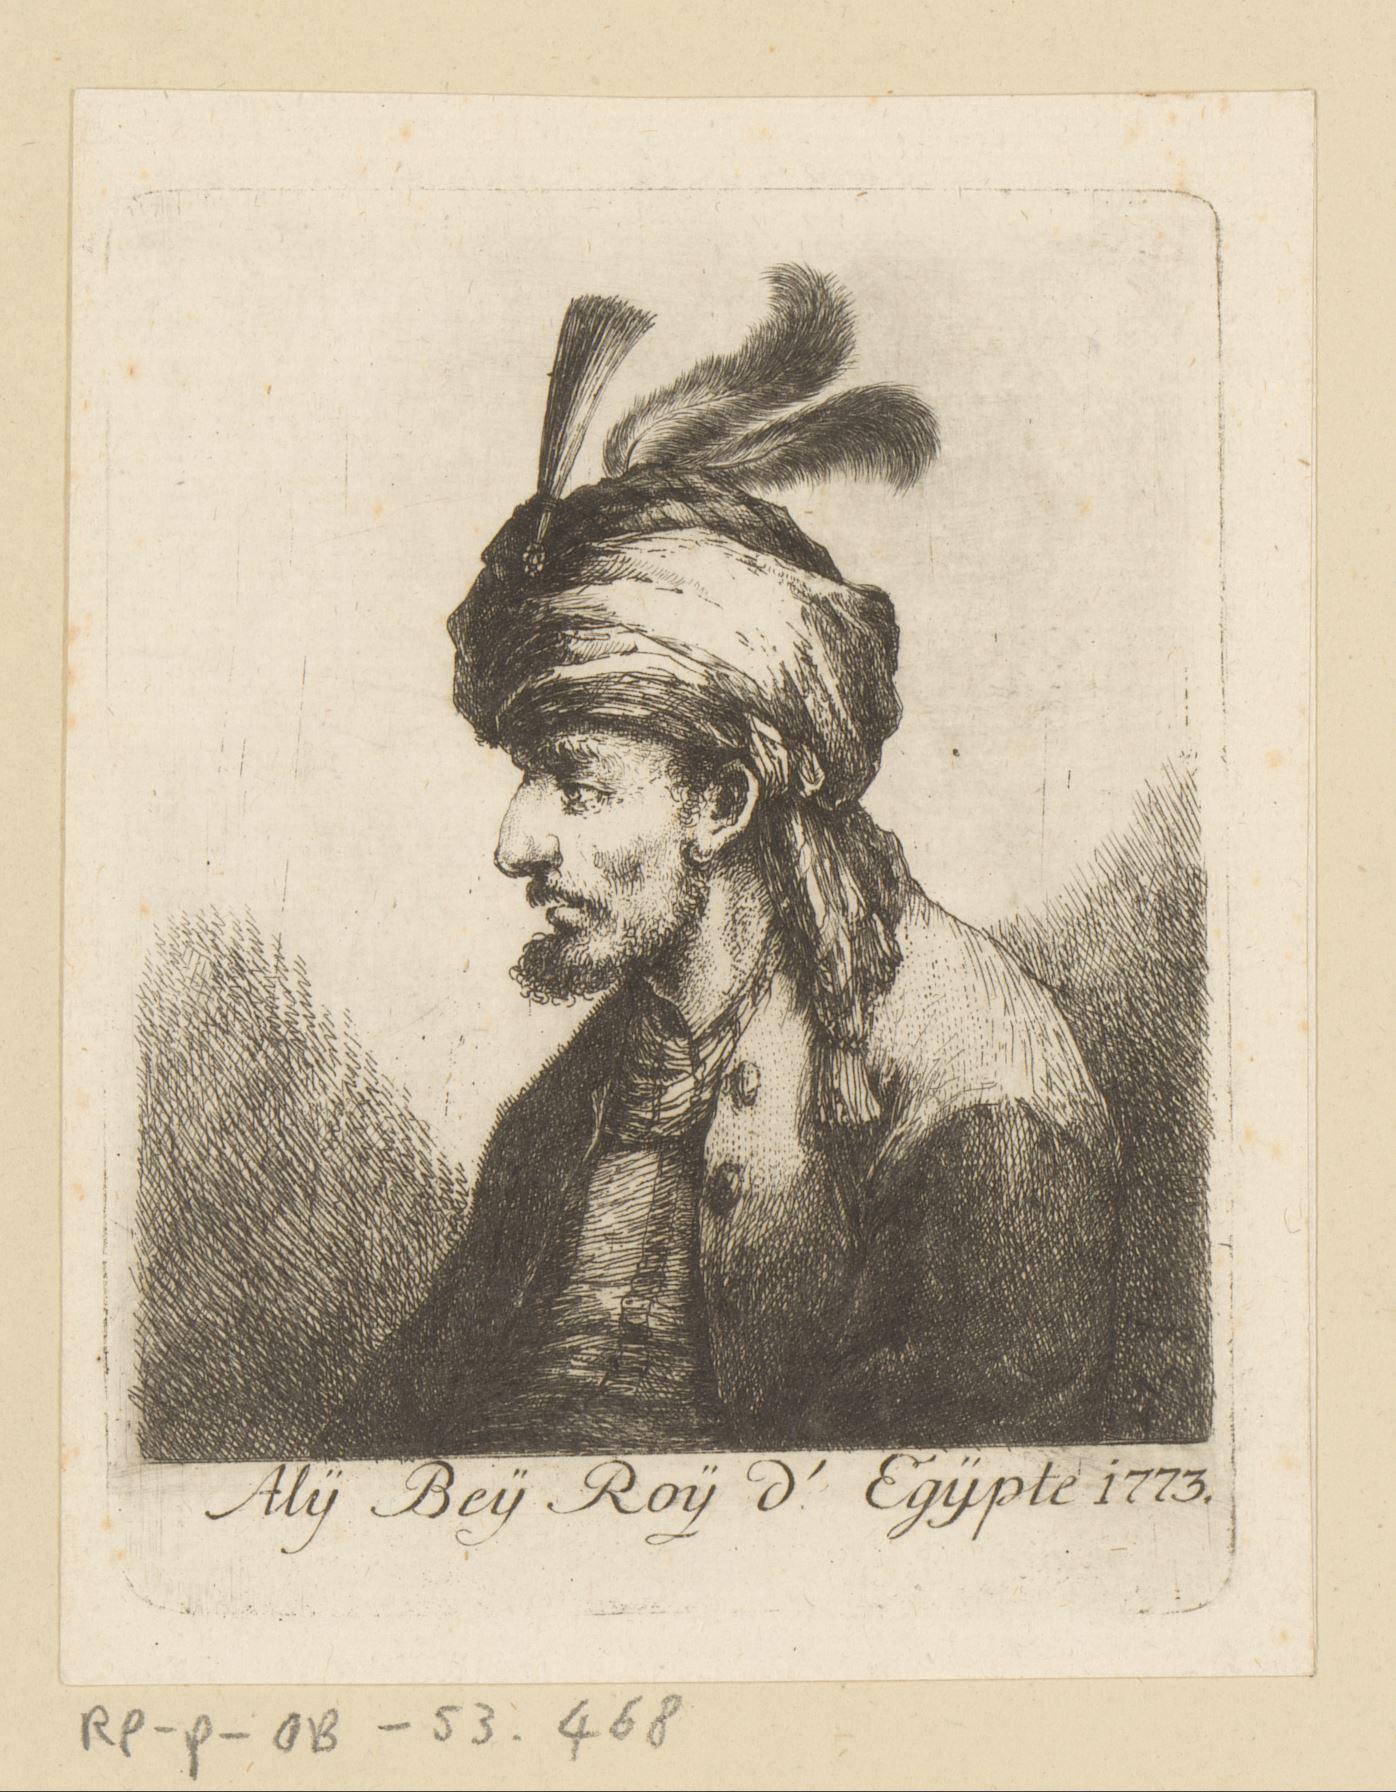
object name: print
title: Portret van Ali Bey al-Kabir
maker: johann andreas benjamin nothnagel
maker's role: print maker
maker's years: 1729-1804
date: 1773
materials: paper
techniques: etching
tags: historical persons, head-gear: turban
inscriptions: collector's mark: Lugt 240